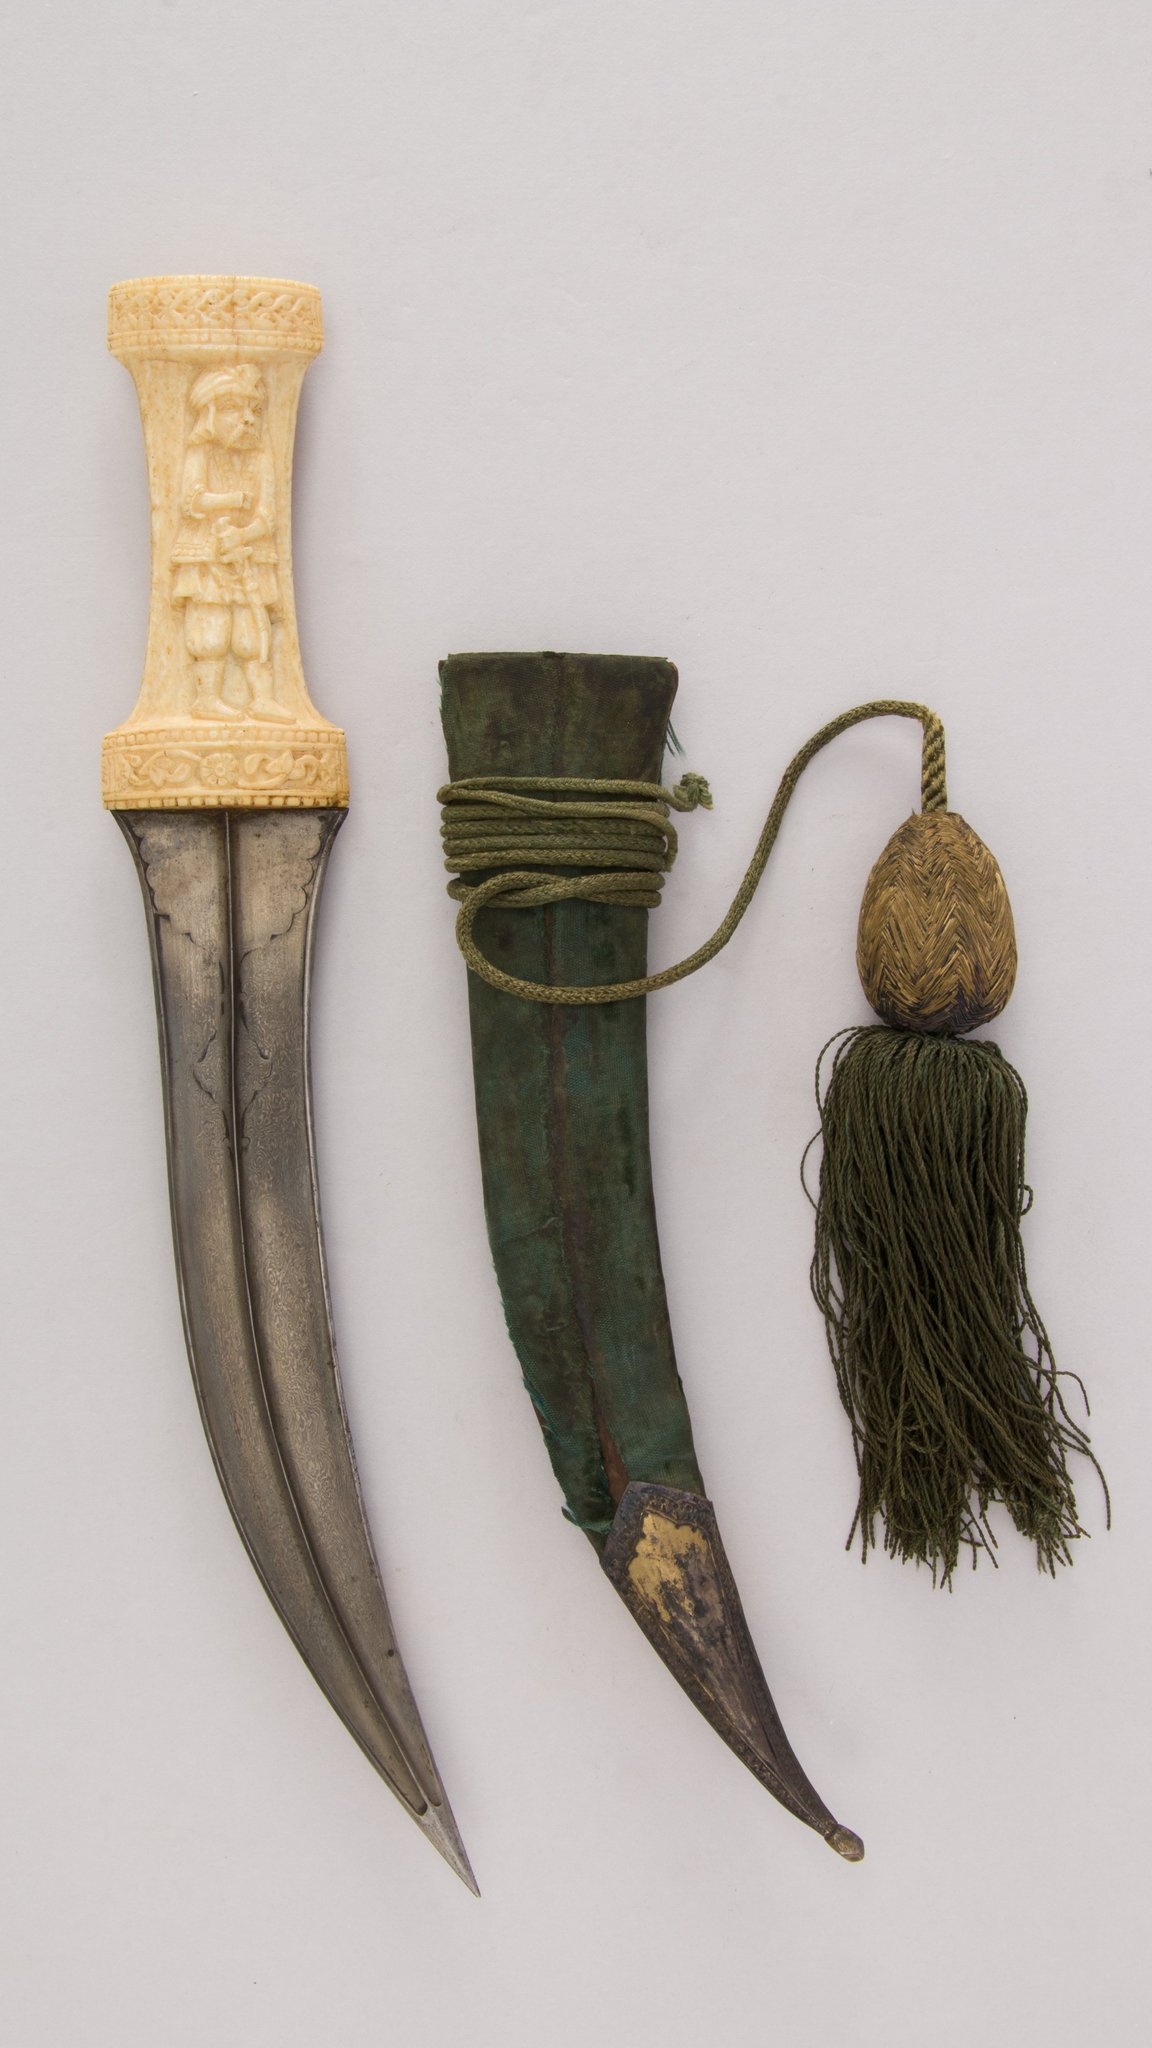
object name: dagger jambiya with sheath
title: Dagger (Jambiya) with Sheath and Cord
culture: persian, qajar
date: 1801-1900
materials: ivory, silk, silver, steel, velvet, wood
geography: iran